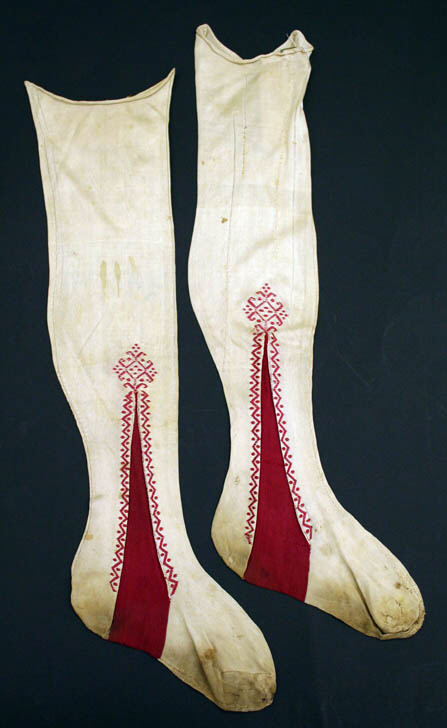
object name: stocking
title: Stockings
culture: italian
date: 1801-1833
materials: silk